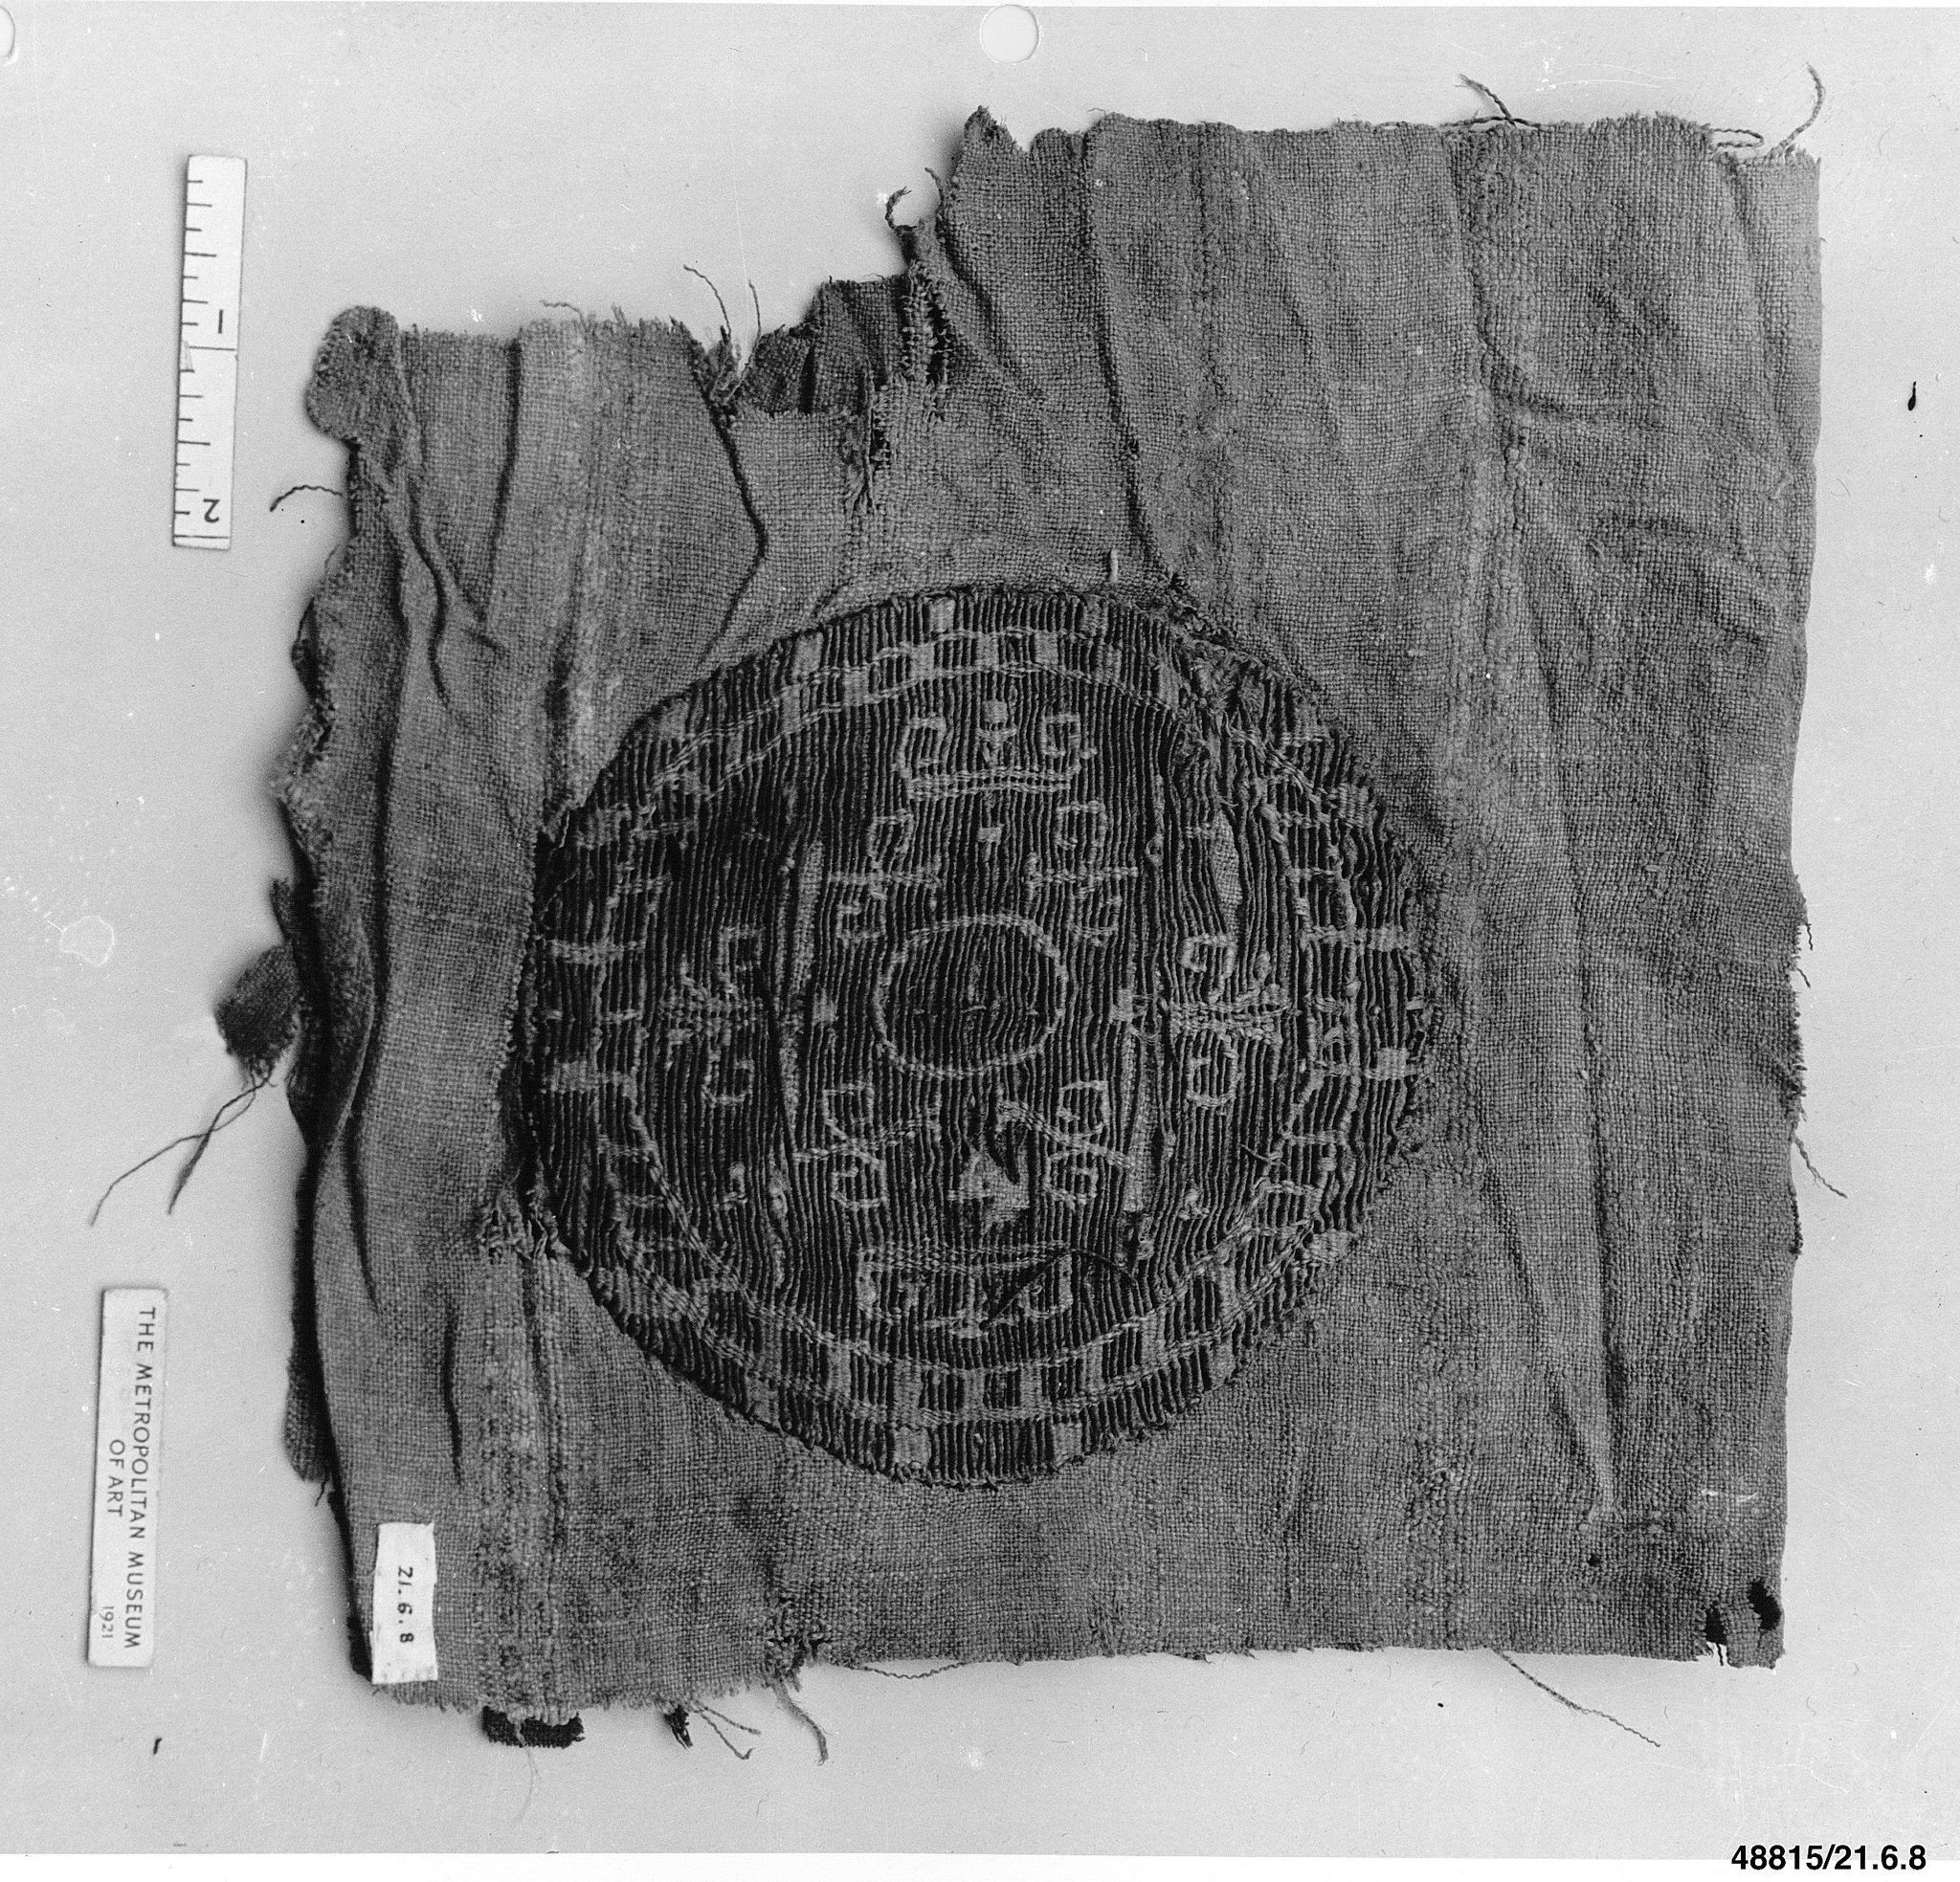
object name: fragment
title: Textile Fragment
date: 401-500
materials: linen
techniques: tapestry, weave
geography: egypt